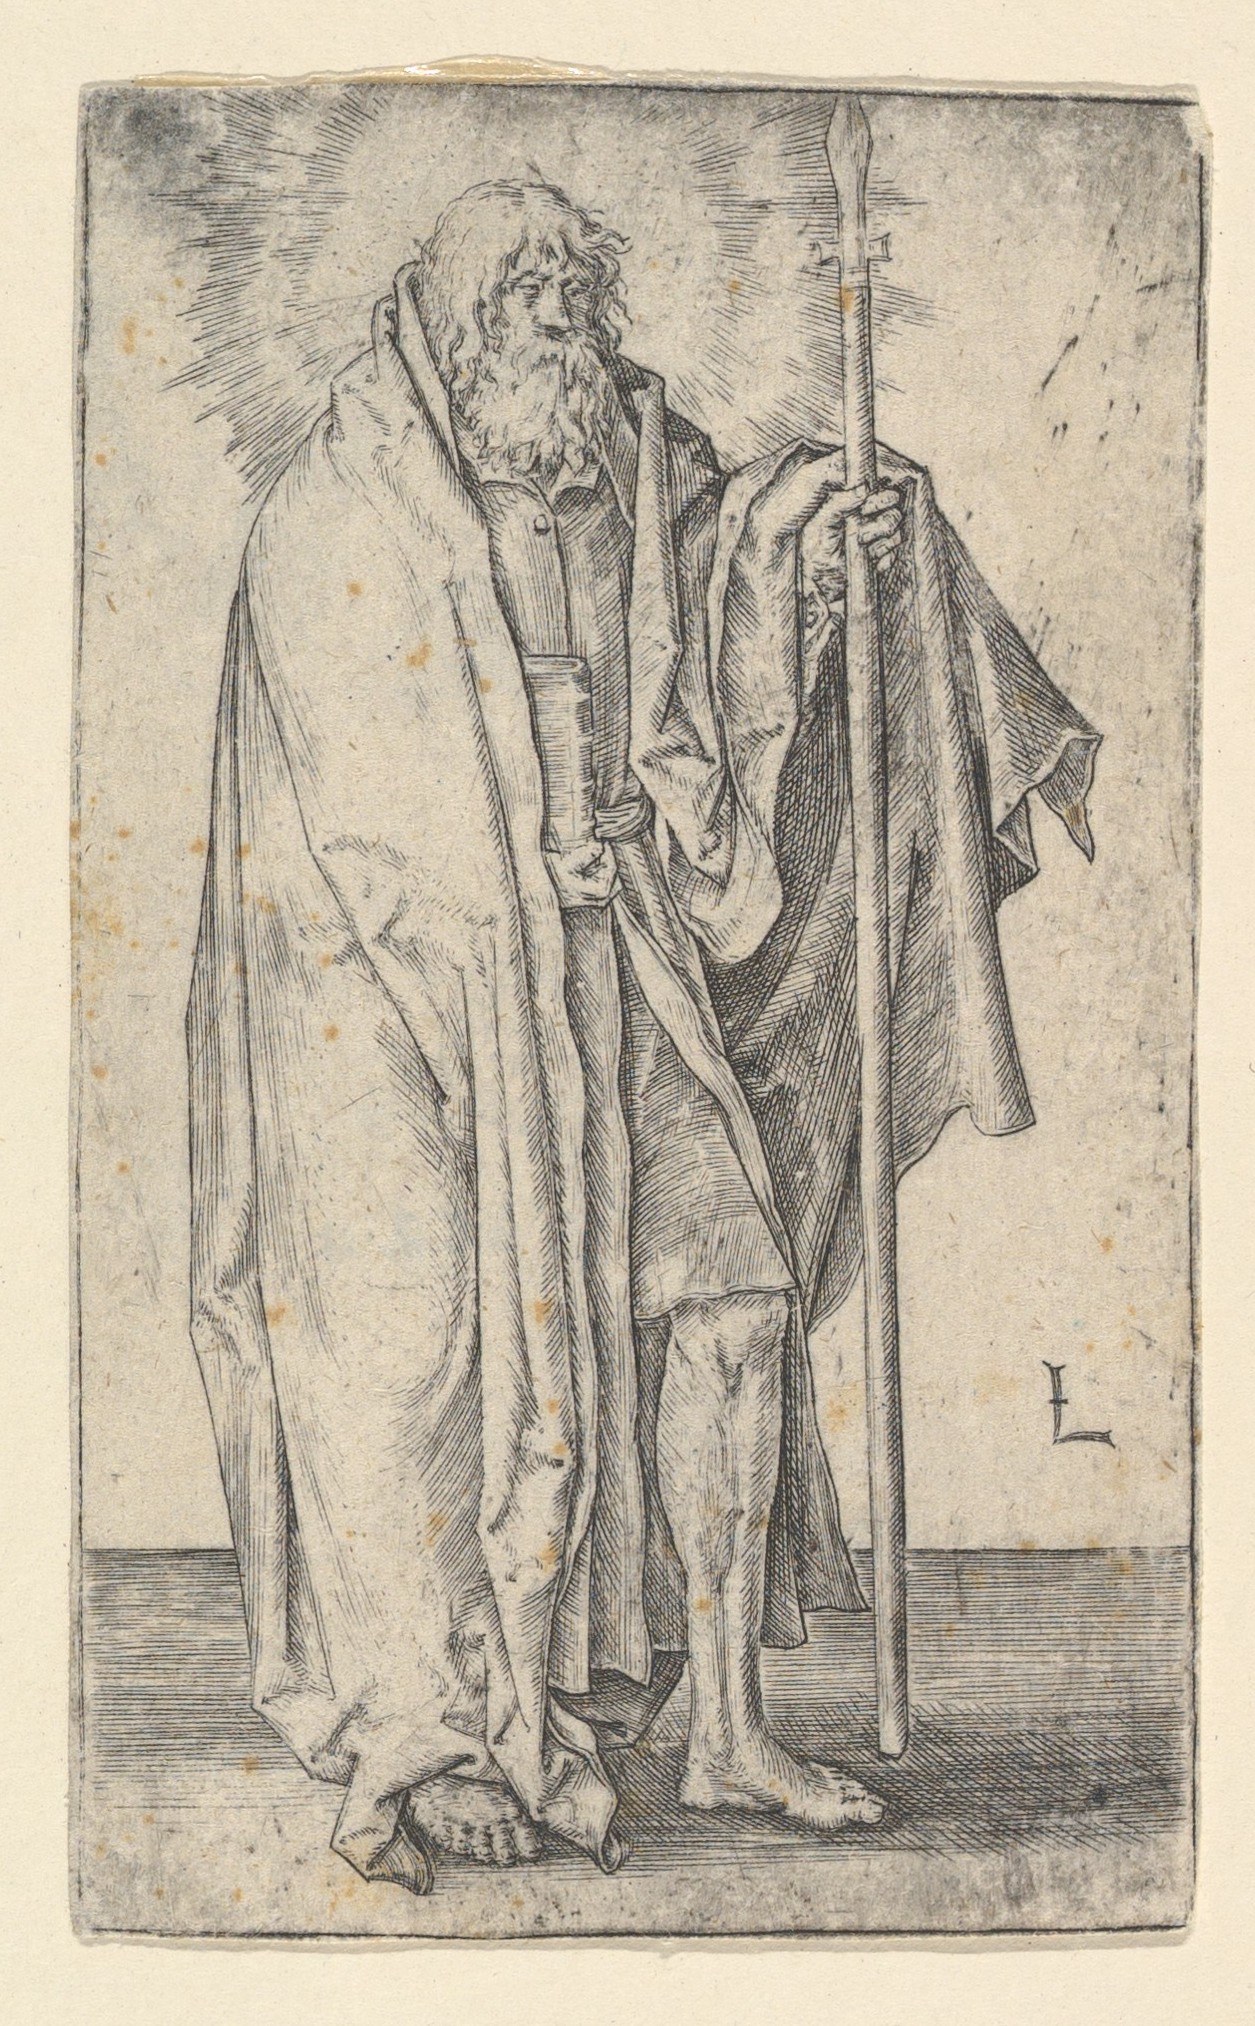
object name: print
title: St. Thomas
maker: lucas van leyden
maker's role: artist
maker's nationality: netherlandish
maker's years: 1494-1533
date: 1510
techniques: engraving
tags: men,saints